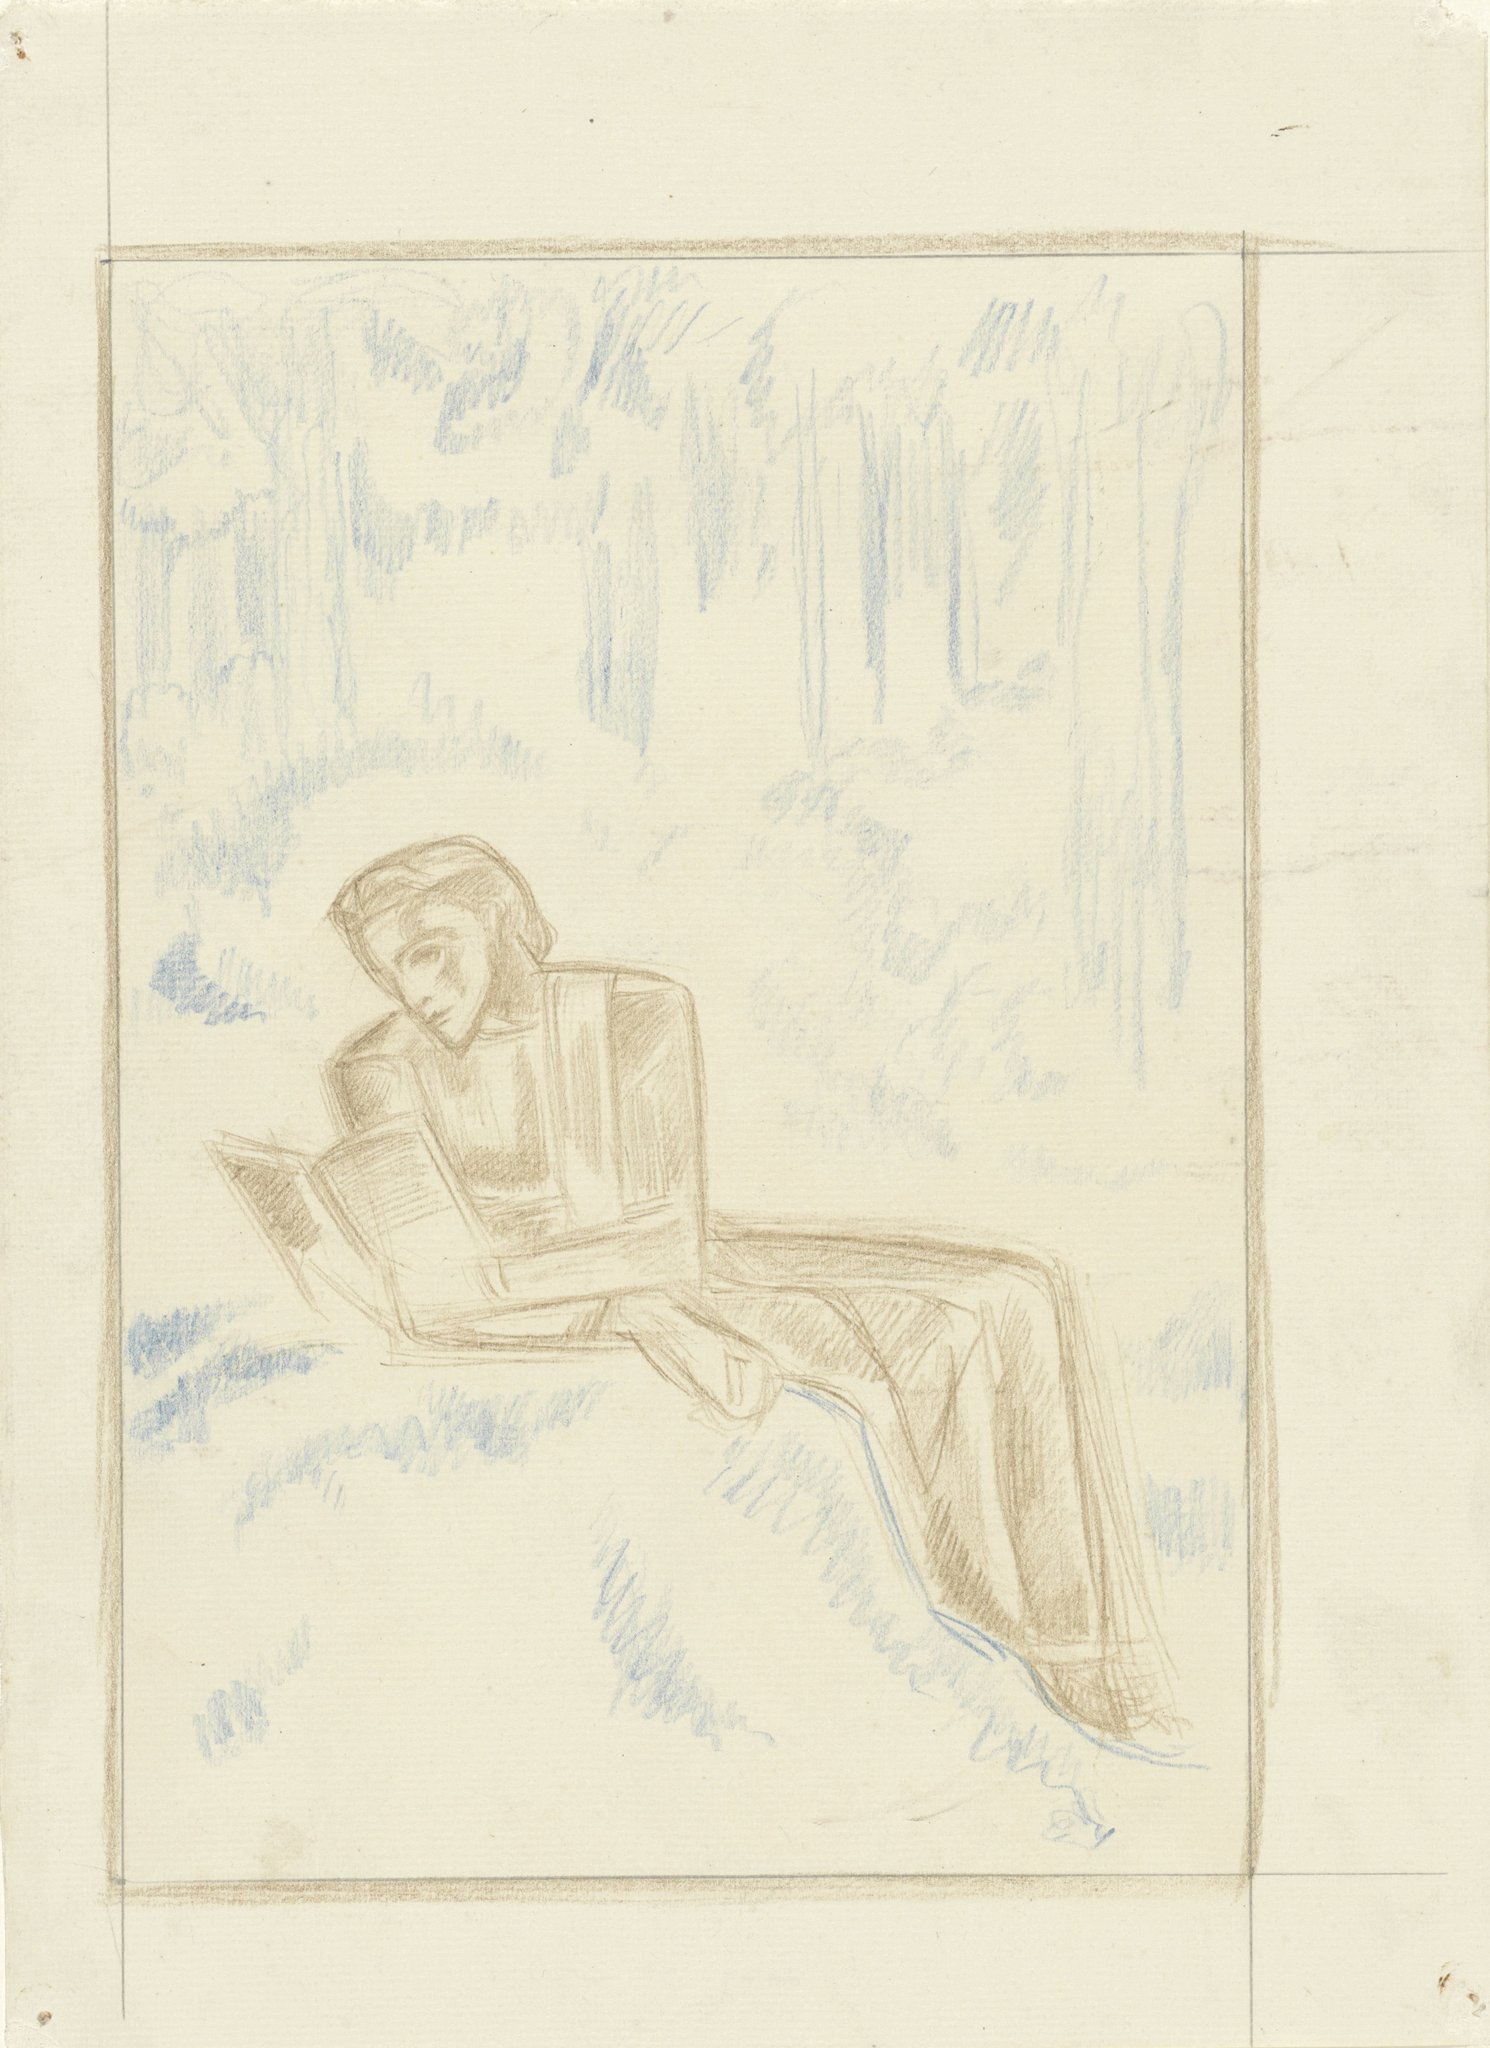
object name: drawing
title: Lezende vrouw in een boslandschap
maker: richard nicolaüs roland holst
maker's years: 1868-1938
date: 1878-1938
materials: chalk, paper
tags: reading, forest, wood